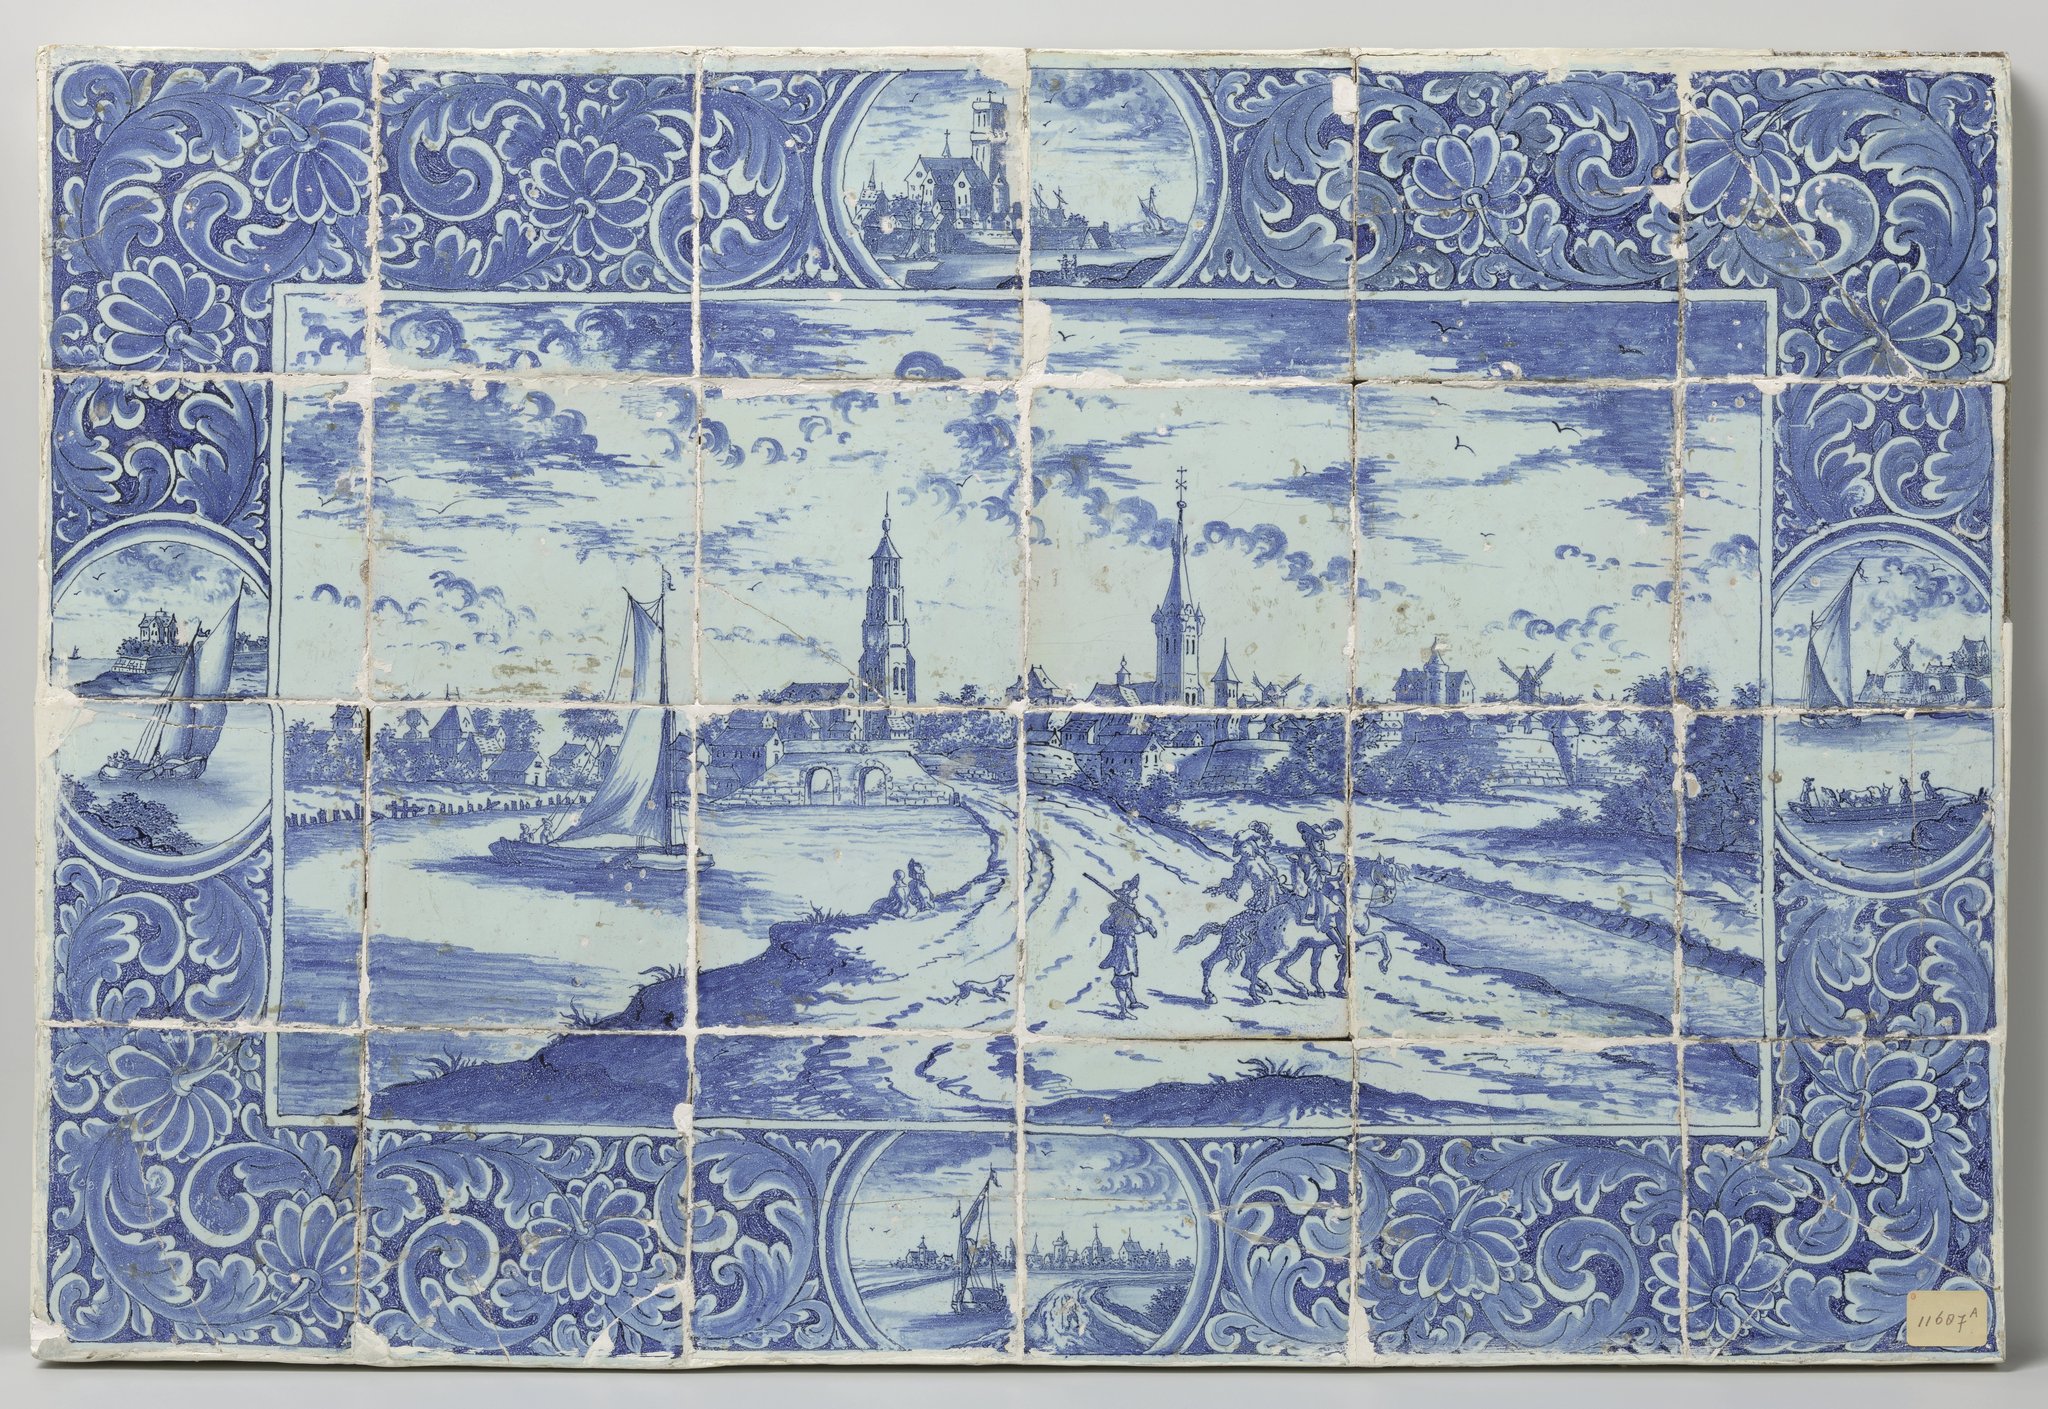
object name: tile tableau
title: Tegeltableau met stadsgezicht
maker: Anonymous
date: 1880-1900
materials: earthenware, glaze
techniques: maiolica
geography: netherlands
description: Tegeltableau van 24 tegels (4 x 6) met een blauw geschilderd stadsgezicht aan het water met op de voorgrond een pad met ruiters. De voorstelling is omlijst door een acanthusrand met vier uitgespaarde medaillons met landschappen.